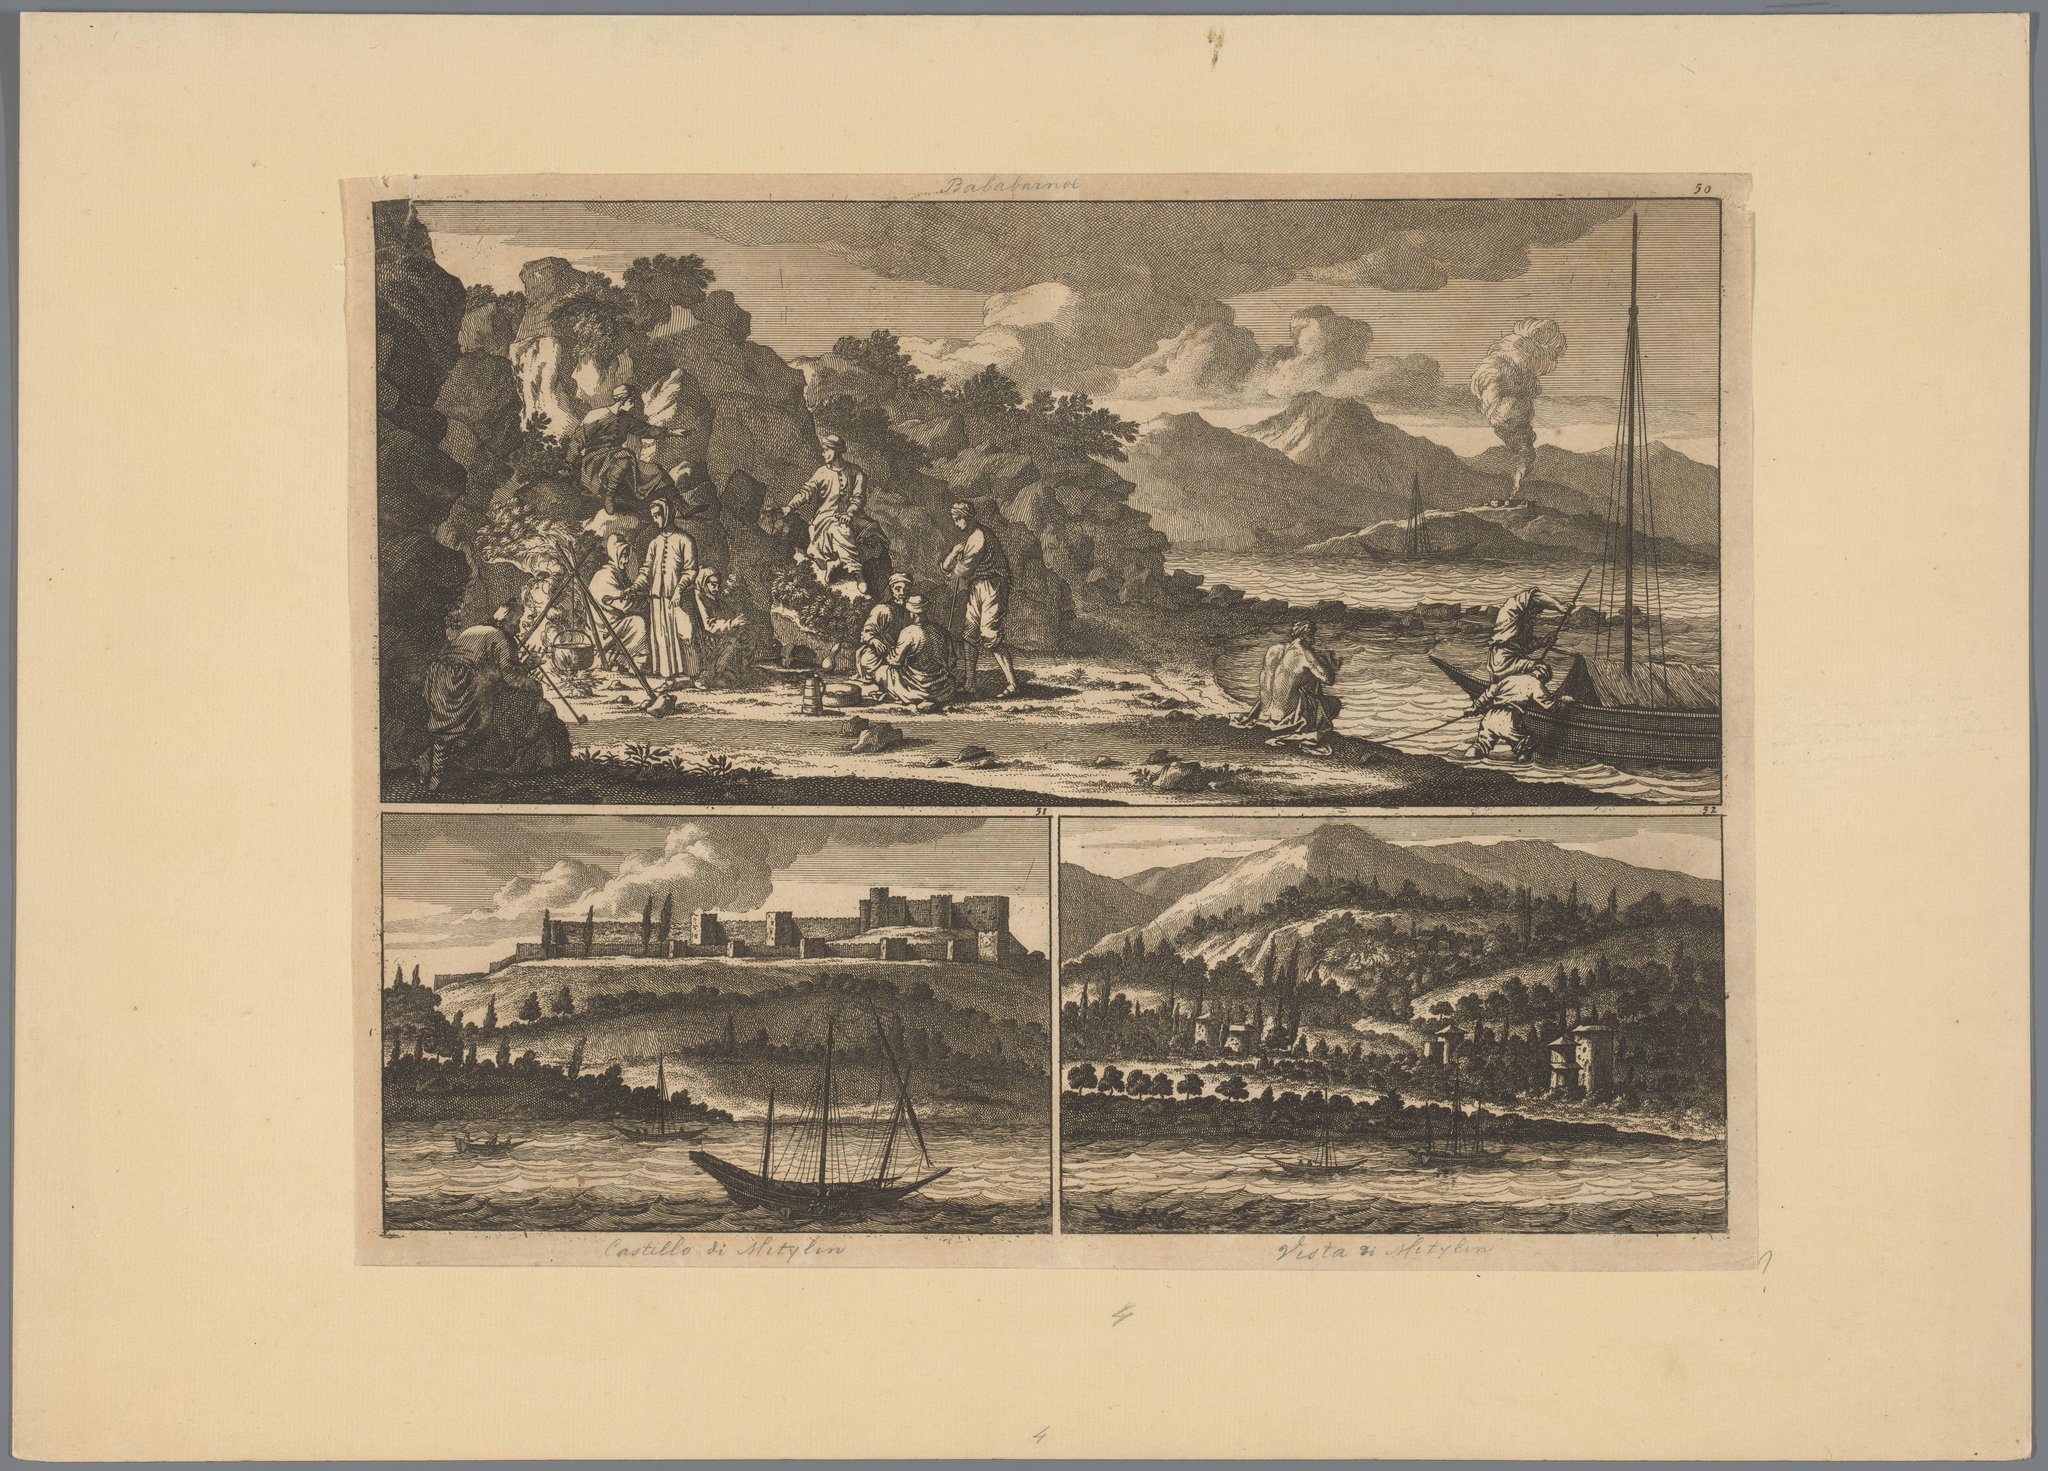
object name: print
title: Groep mannen aan oever van meer verpozend; Castello di Mitylin; Vista di Mitylin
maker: jan luyken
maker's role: draughtsman, print maker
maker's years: 1649-1712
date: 1659-1712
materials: paper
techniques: etching